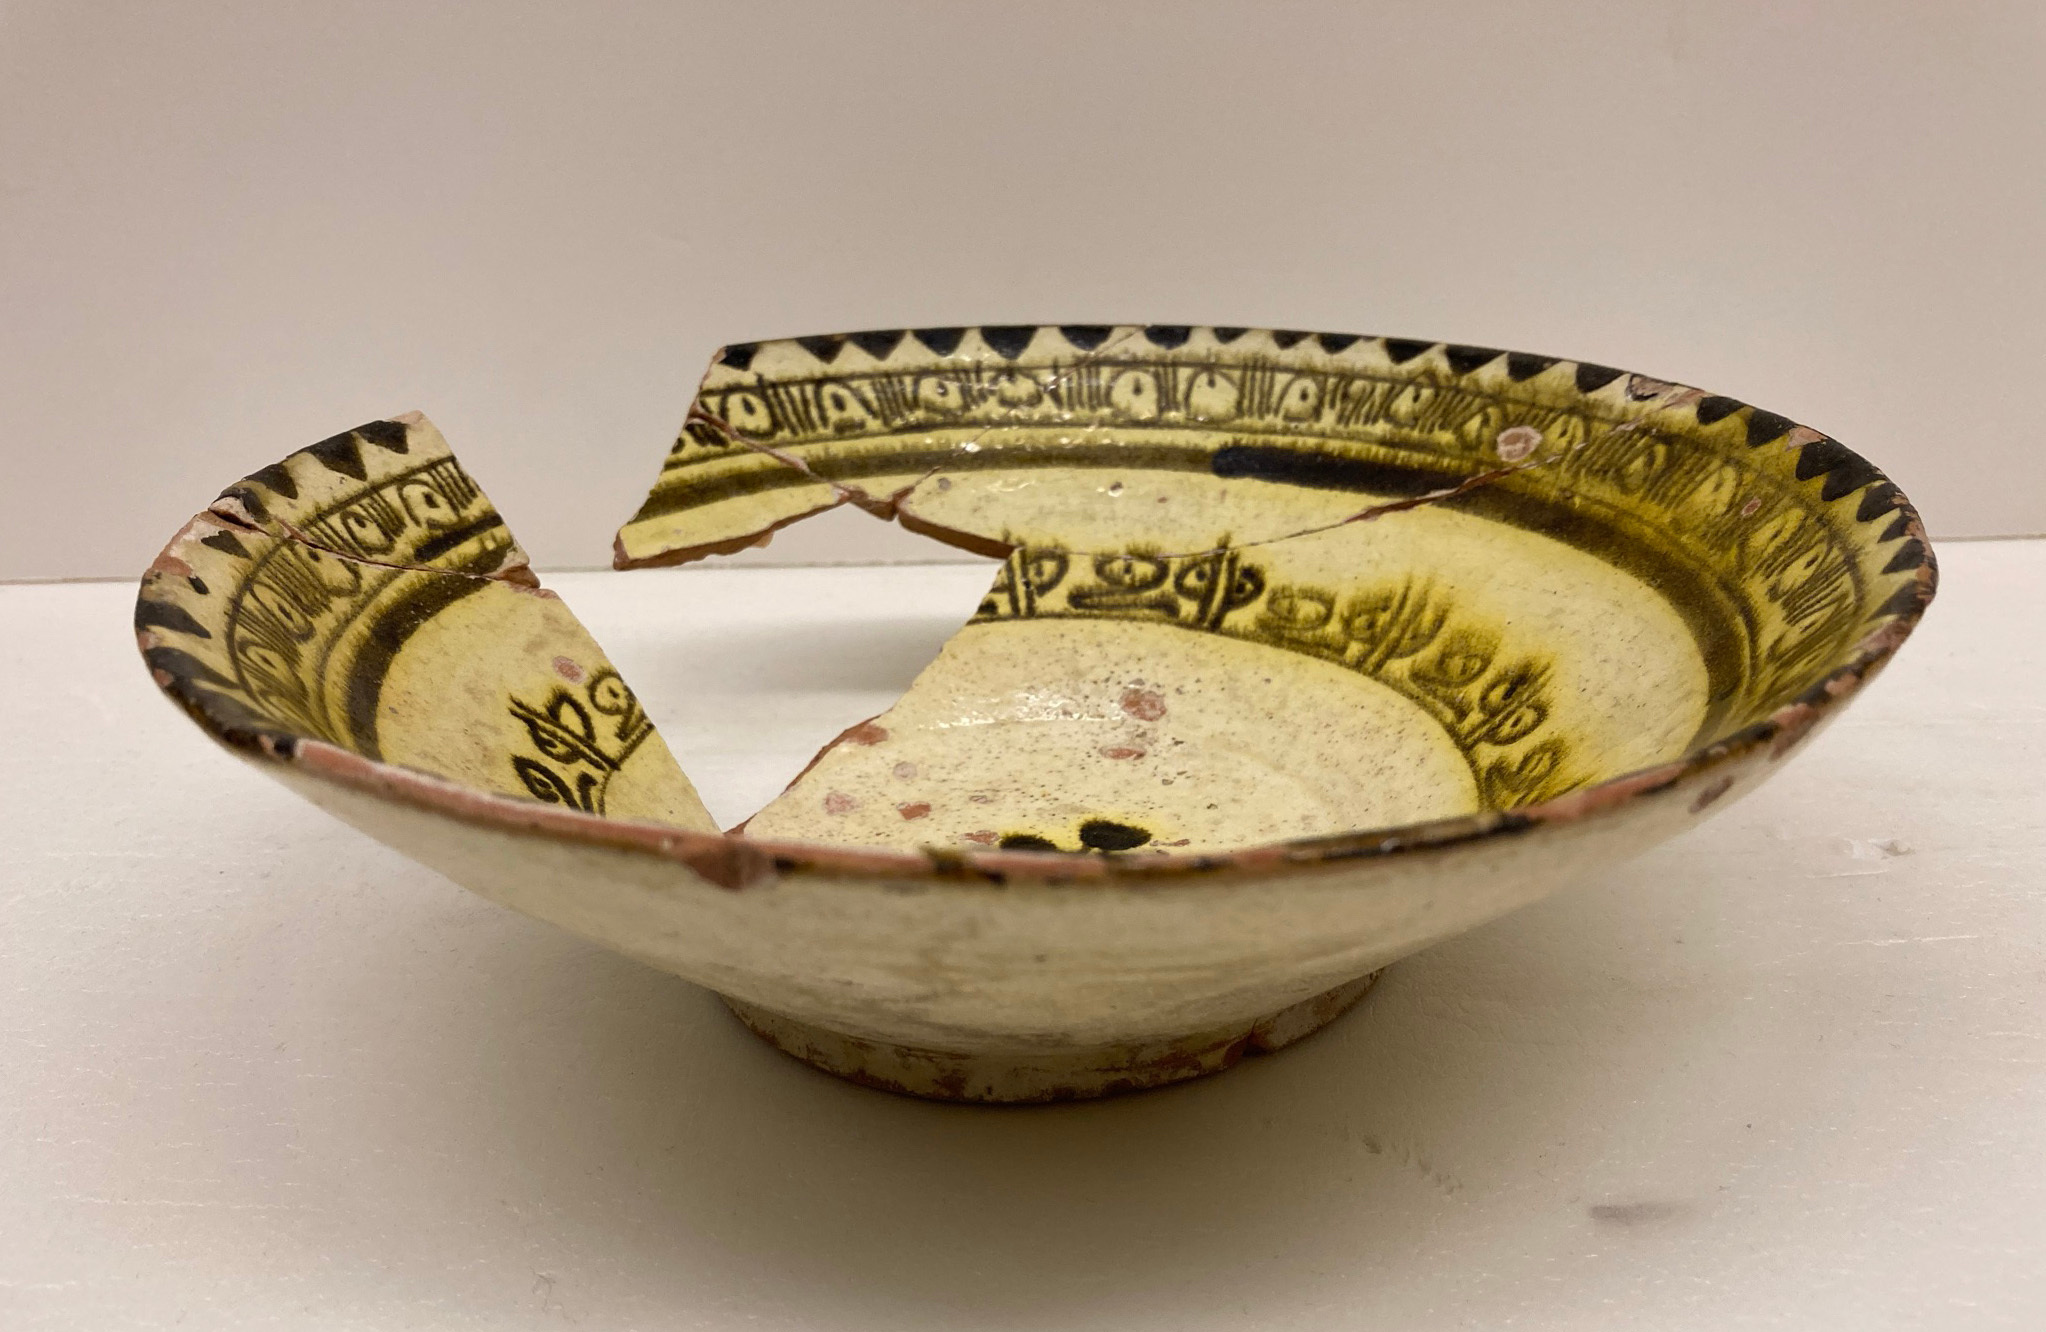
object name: bowl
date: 801-900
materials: earthenware, glaze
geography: iran